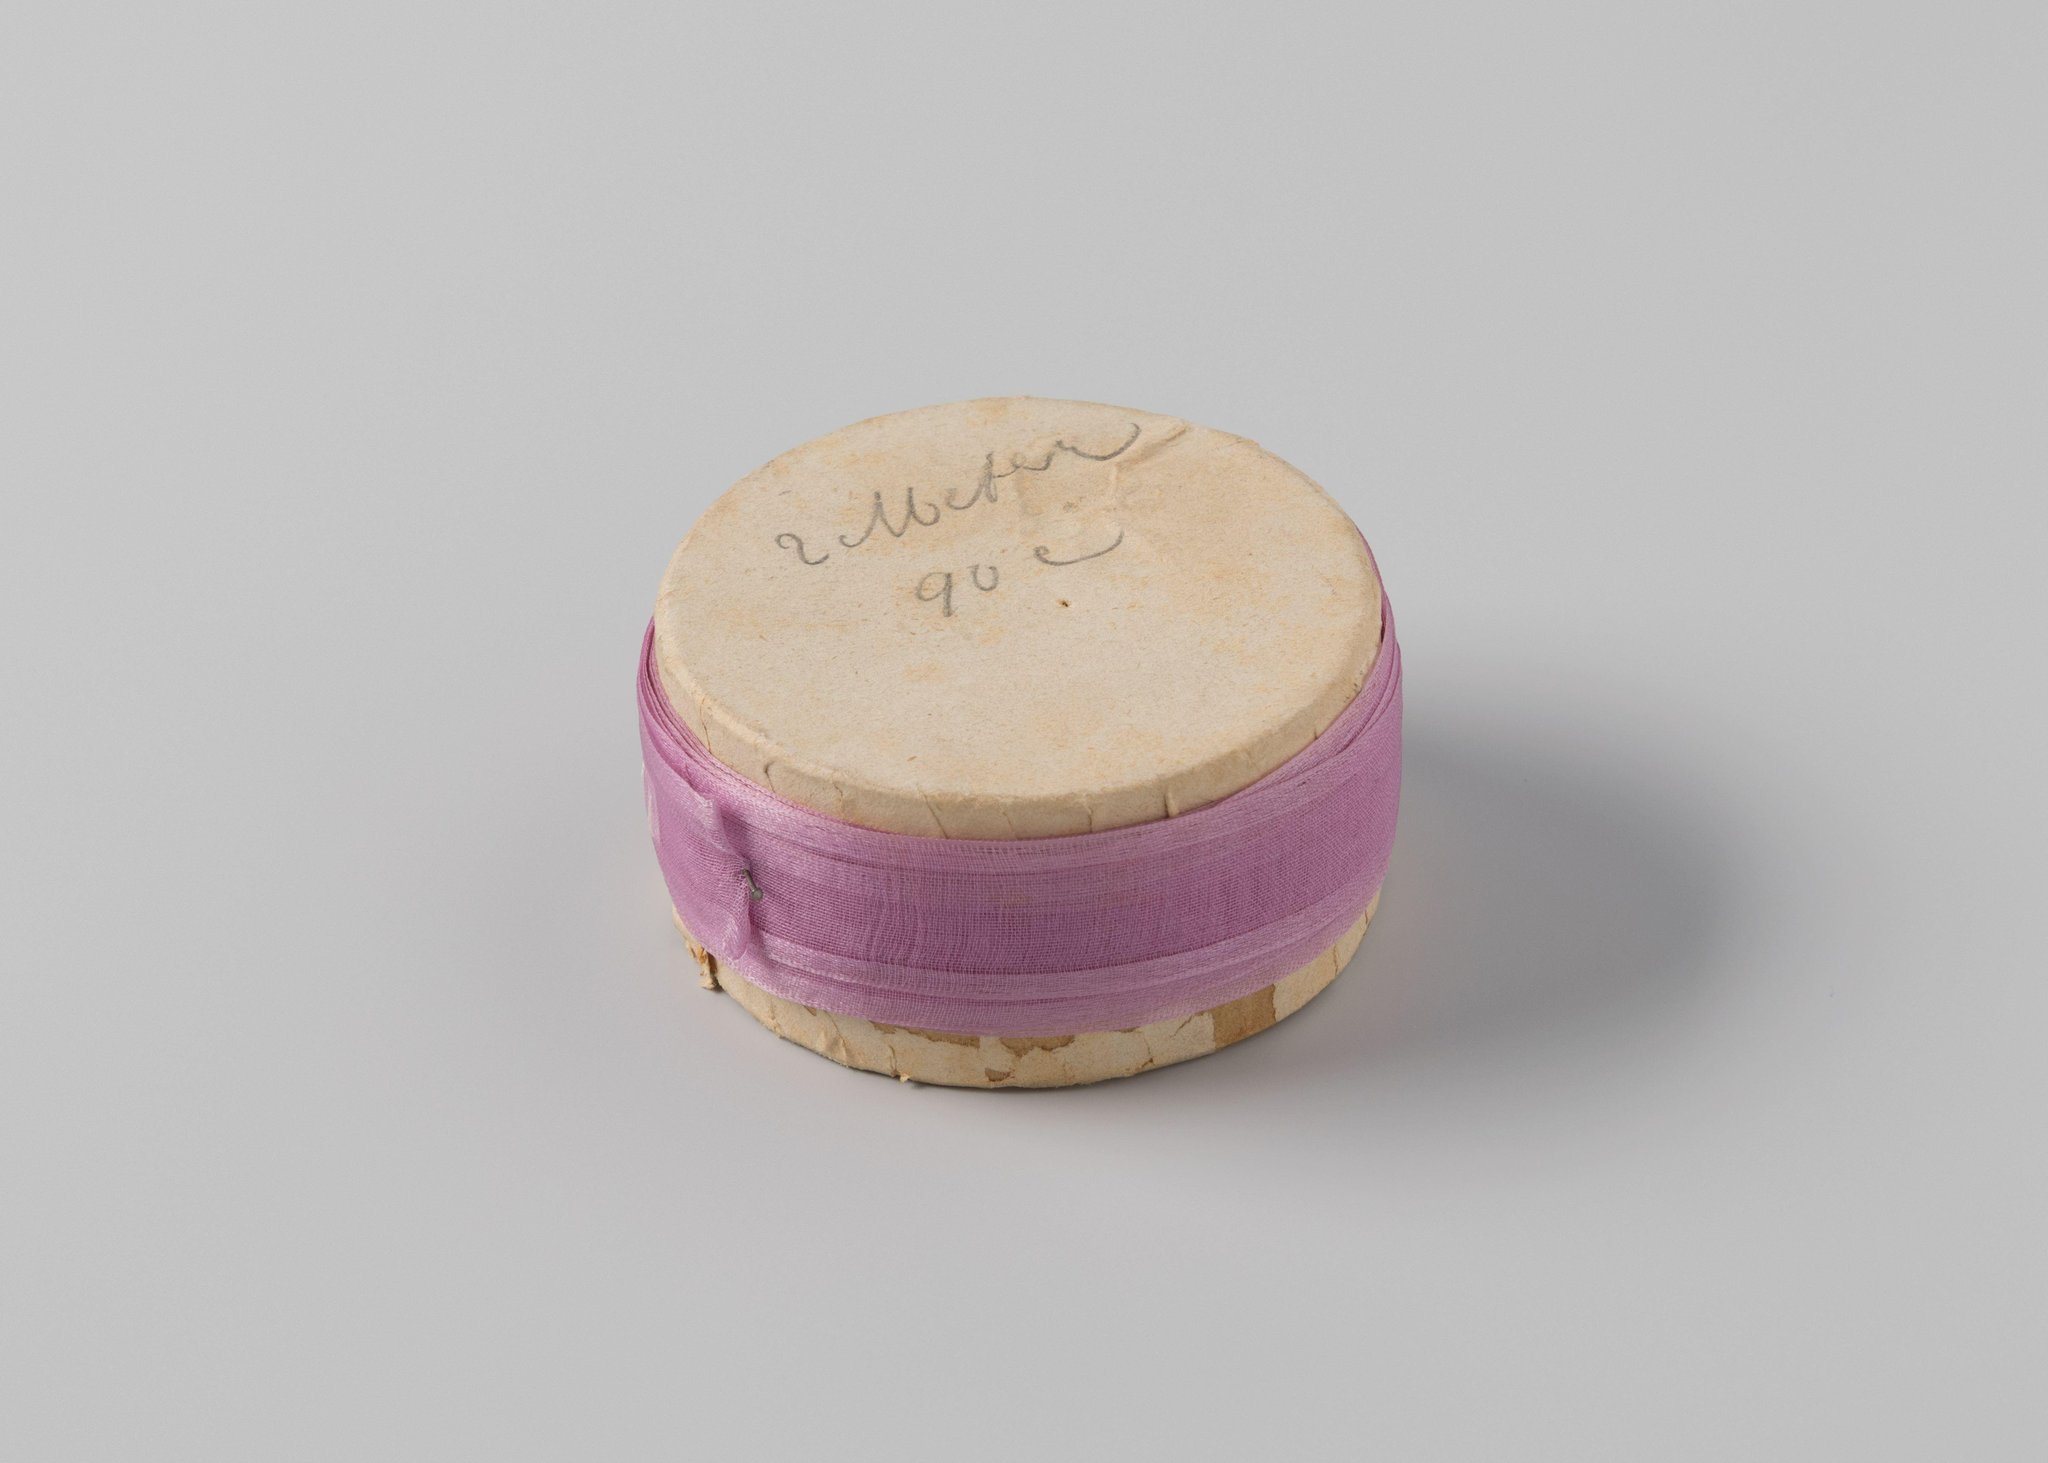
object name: braid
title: Lint van lila gaas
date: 1900-1915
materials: textile, silk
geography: france